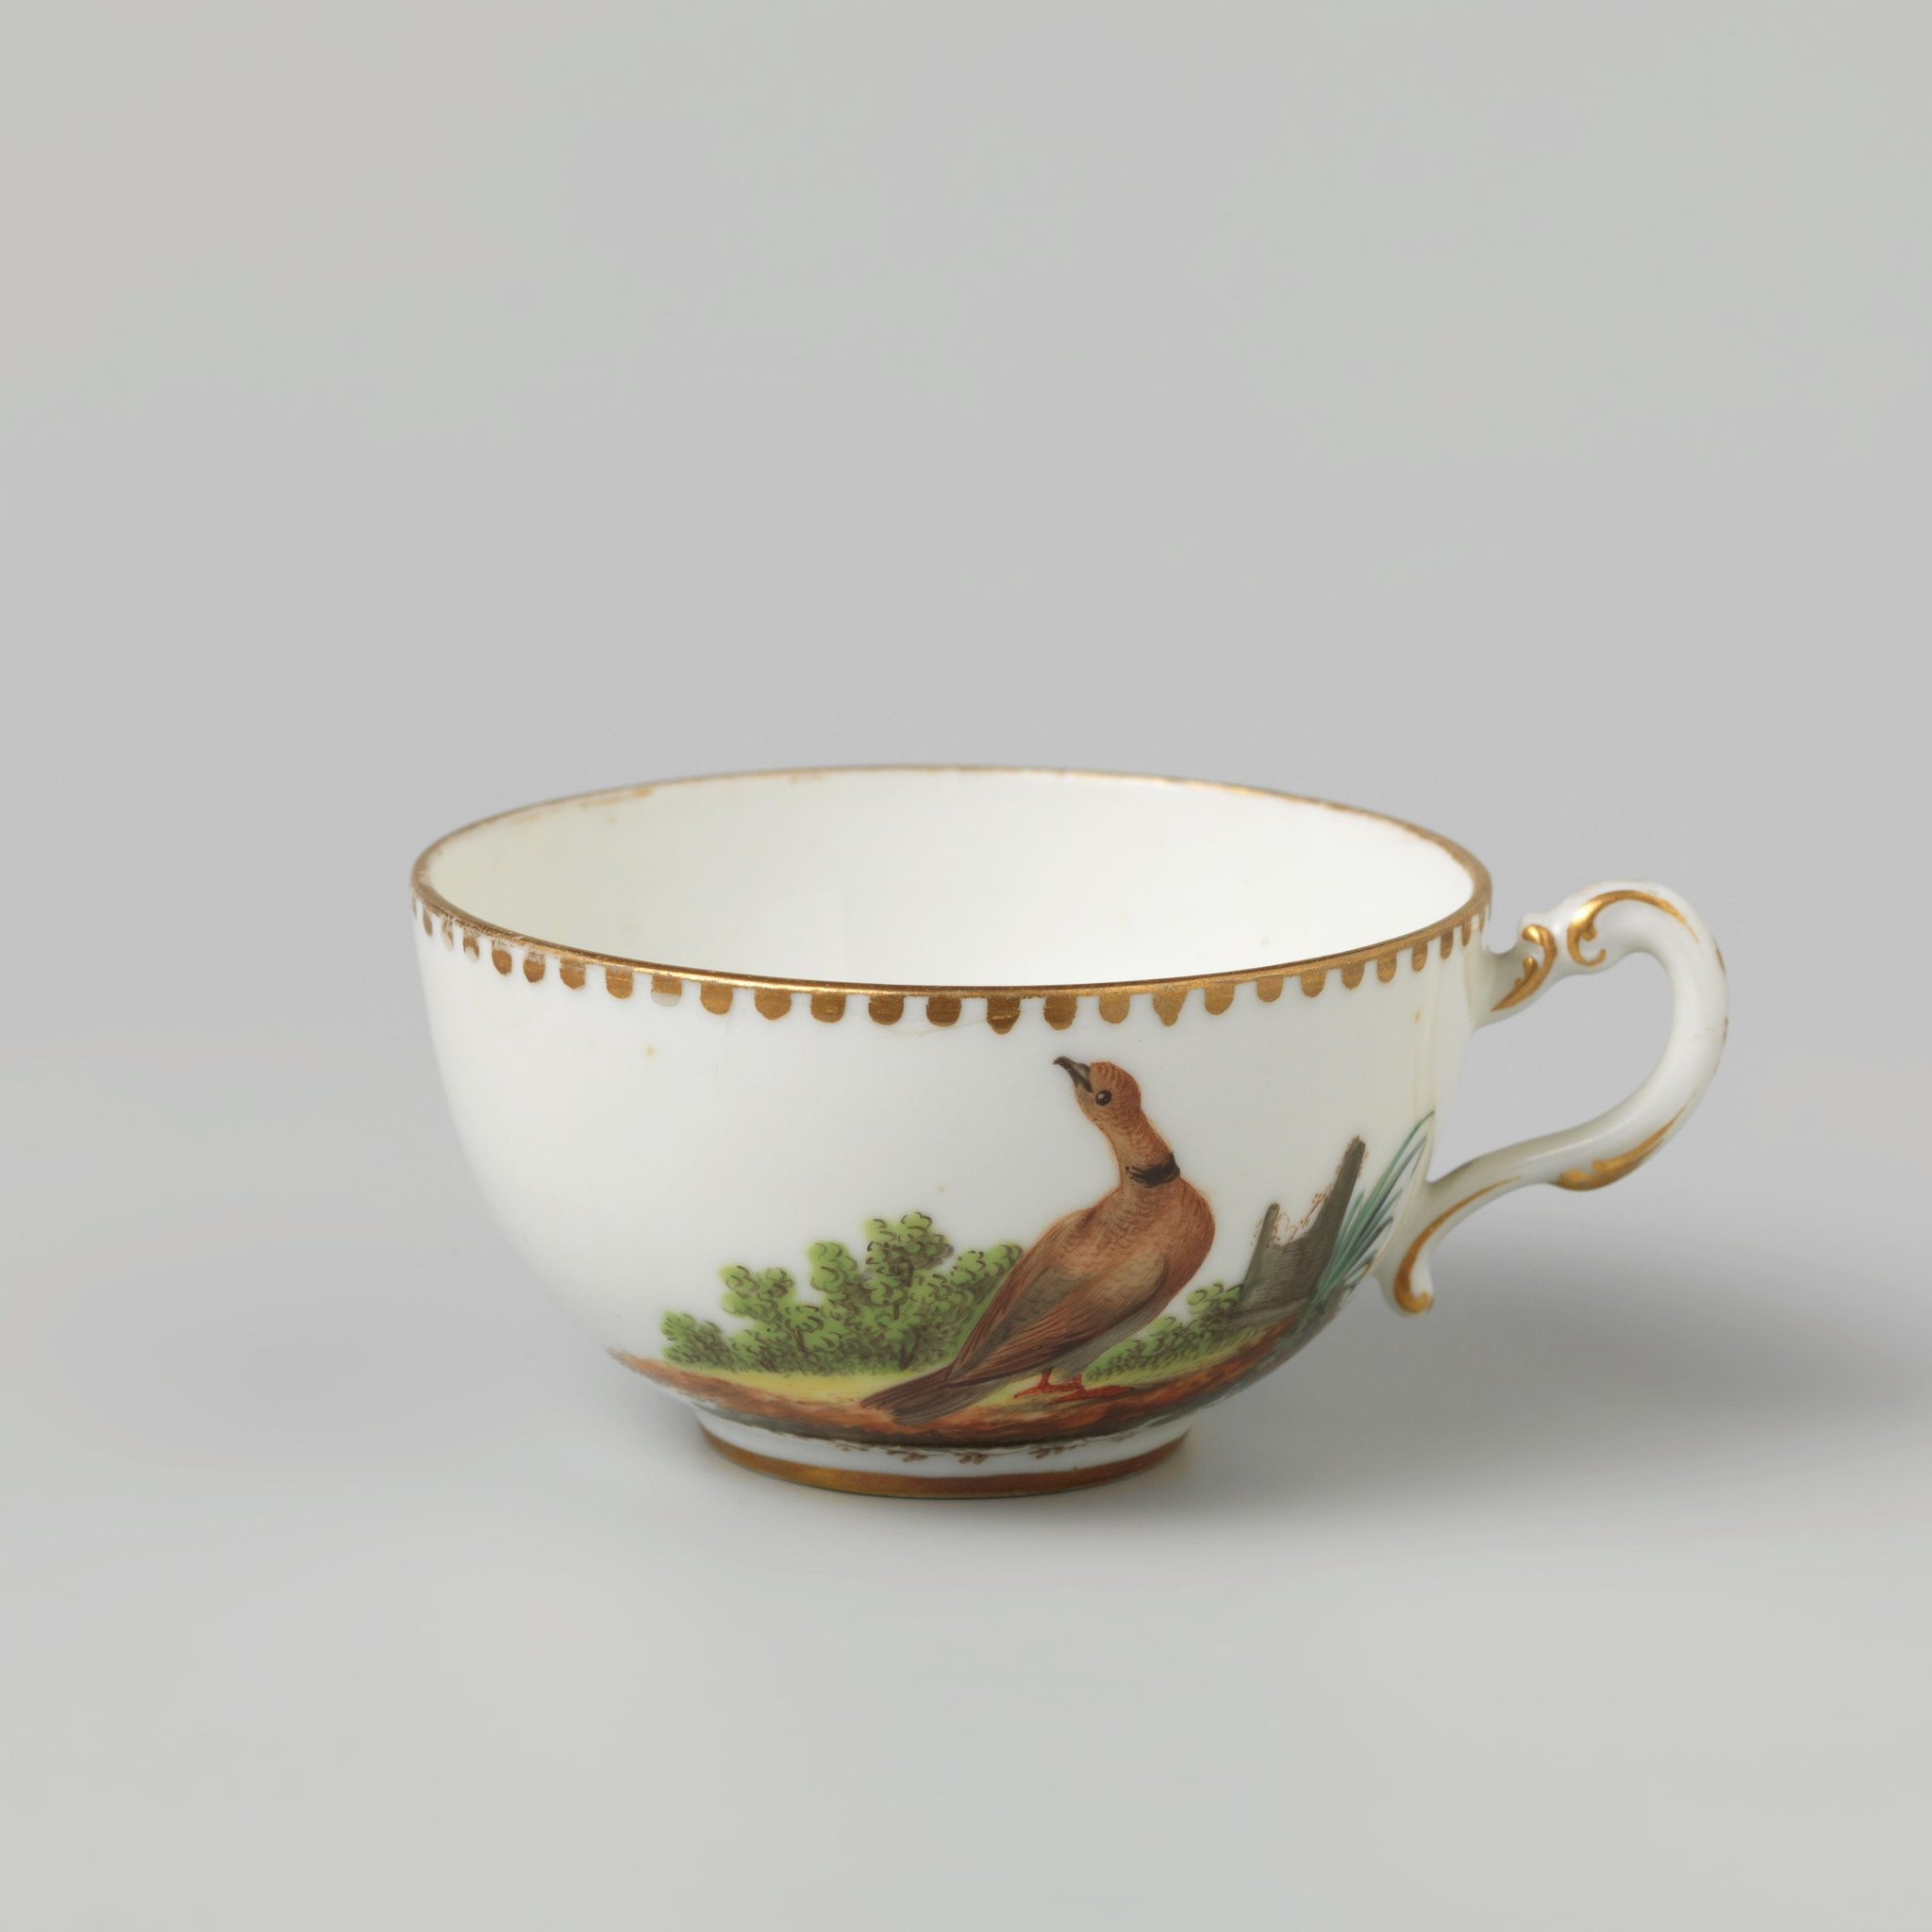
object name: cup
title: Kop, beschilderd met pluimvee in een landschap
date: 1782-1784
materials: porcelain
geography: loosdrecht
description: Kop met oor van porselein. Veelkleurig beschilderd met vogels op een landschapsgrondje, en strooibloemen.